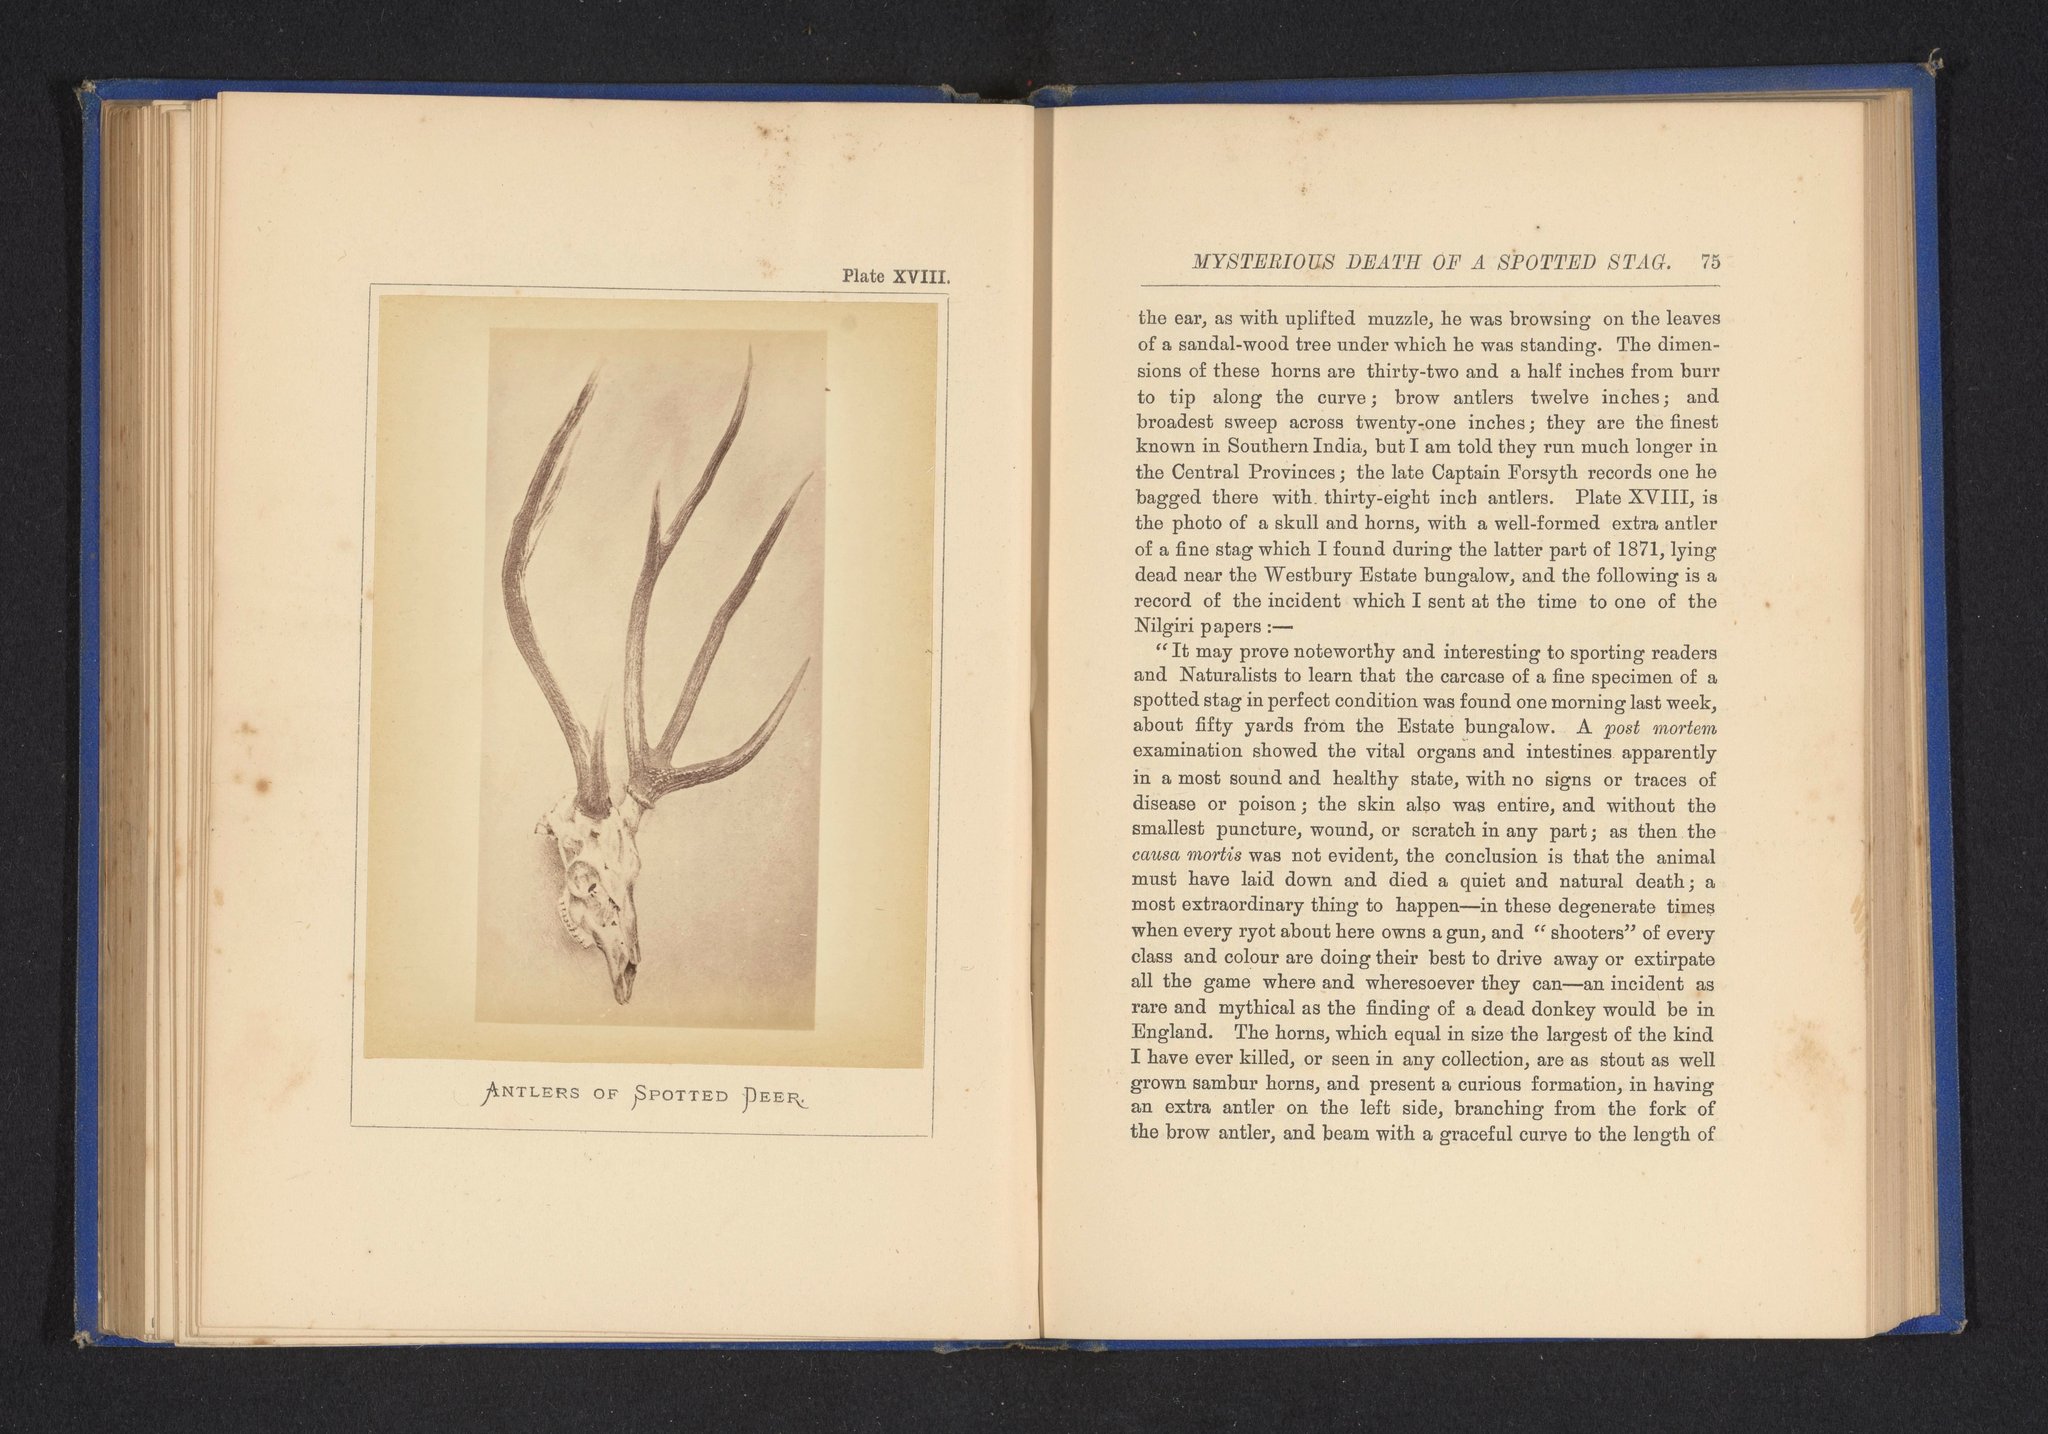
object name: photograph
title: Schedel met gewei van een axishert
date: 1870-1880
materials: photographic support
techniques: albumen print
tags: hoofed animals: deer, hunting trophies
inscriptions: number: ‘Plate XVIII.’